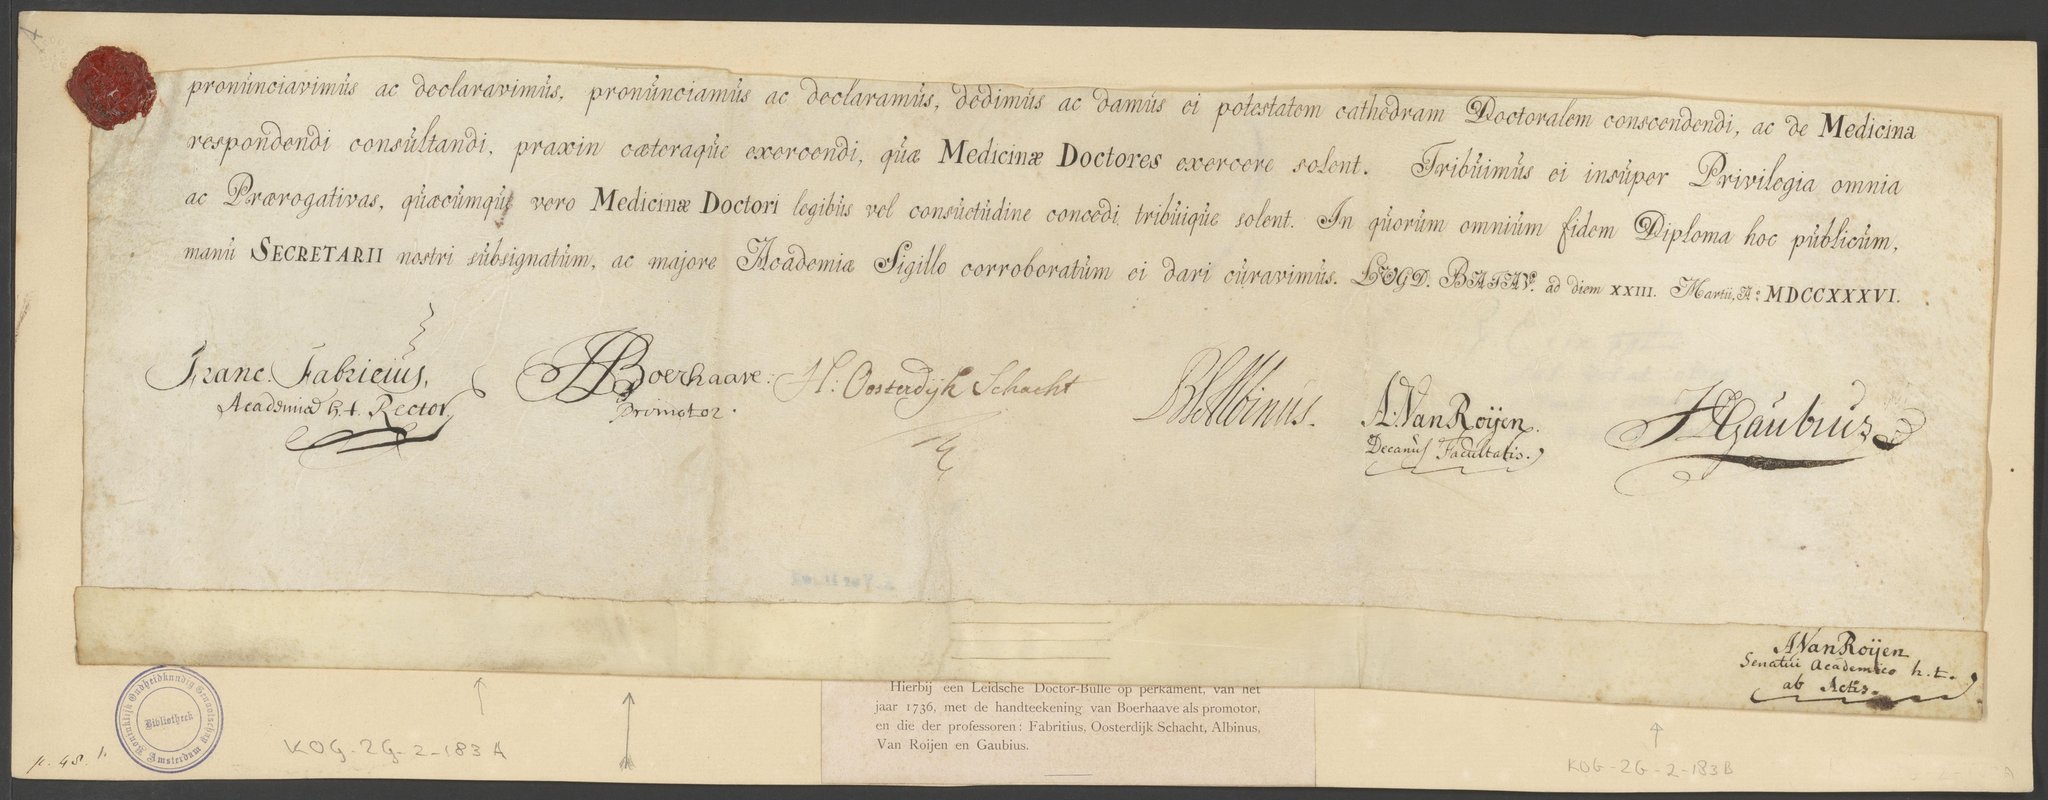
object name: manuscript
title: Fragment van een doctorsbul met handtekening van Boerhaave, 1737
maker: hermanus boerhaave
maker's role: botanicus, chemicus, geneeskundige, hoogleraar, scheikundige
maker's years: 1668-1738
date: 1736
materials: parchment, wax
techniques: writing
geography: leiden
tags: bernard siegfried albinus, amsterdam, leiden, franciscus fabricius, hermanus boerhaave, university diploma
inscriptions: collector's mark: Lugt 2488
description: Fragment van een doctorsbul van de Universiteit van Leiden met de handtekening van Boerhaave als promotor, 23 Maart 1737. Met ook de handtekeningen van de professoren Fabricius, Oosterdijk Schacht, Albinus, Van Roijen en Gaubius. Met lakzegel.